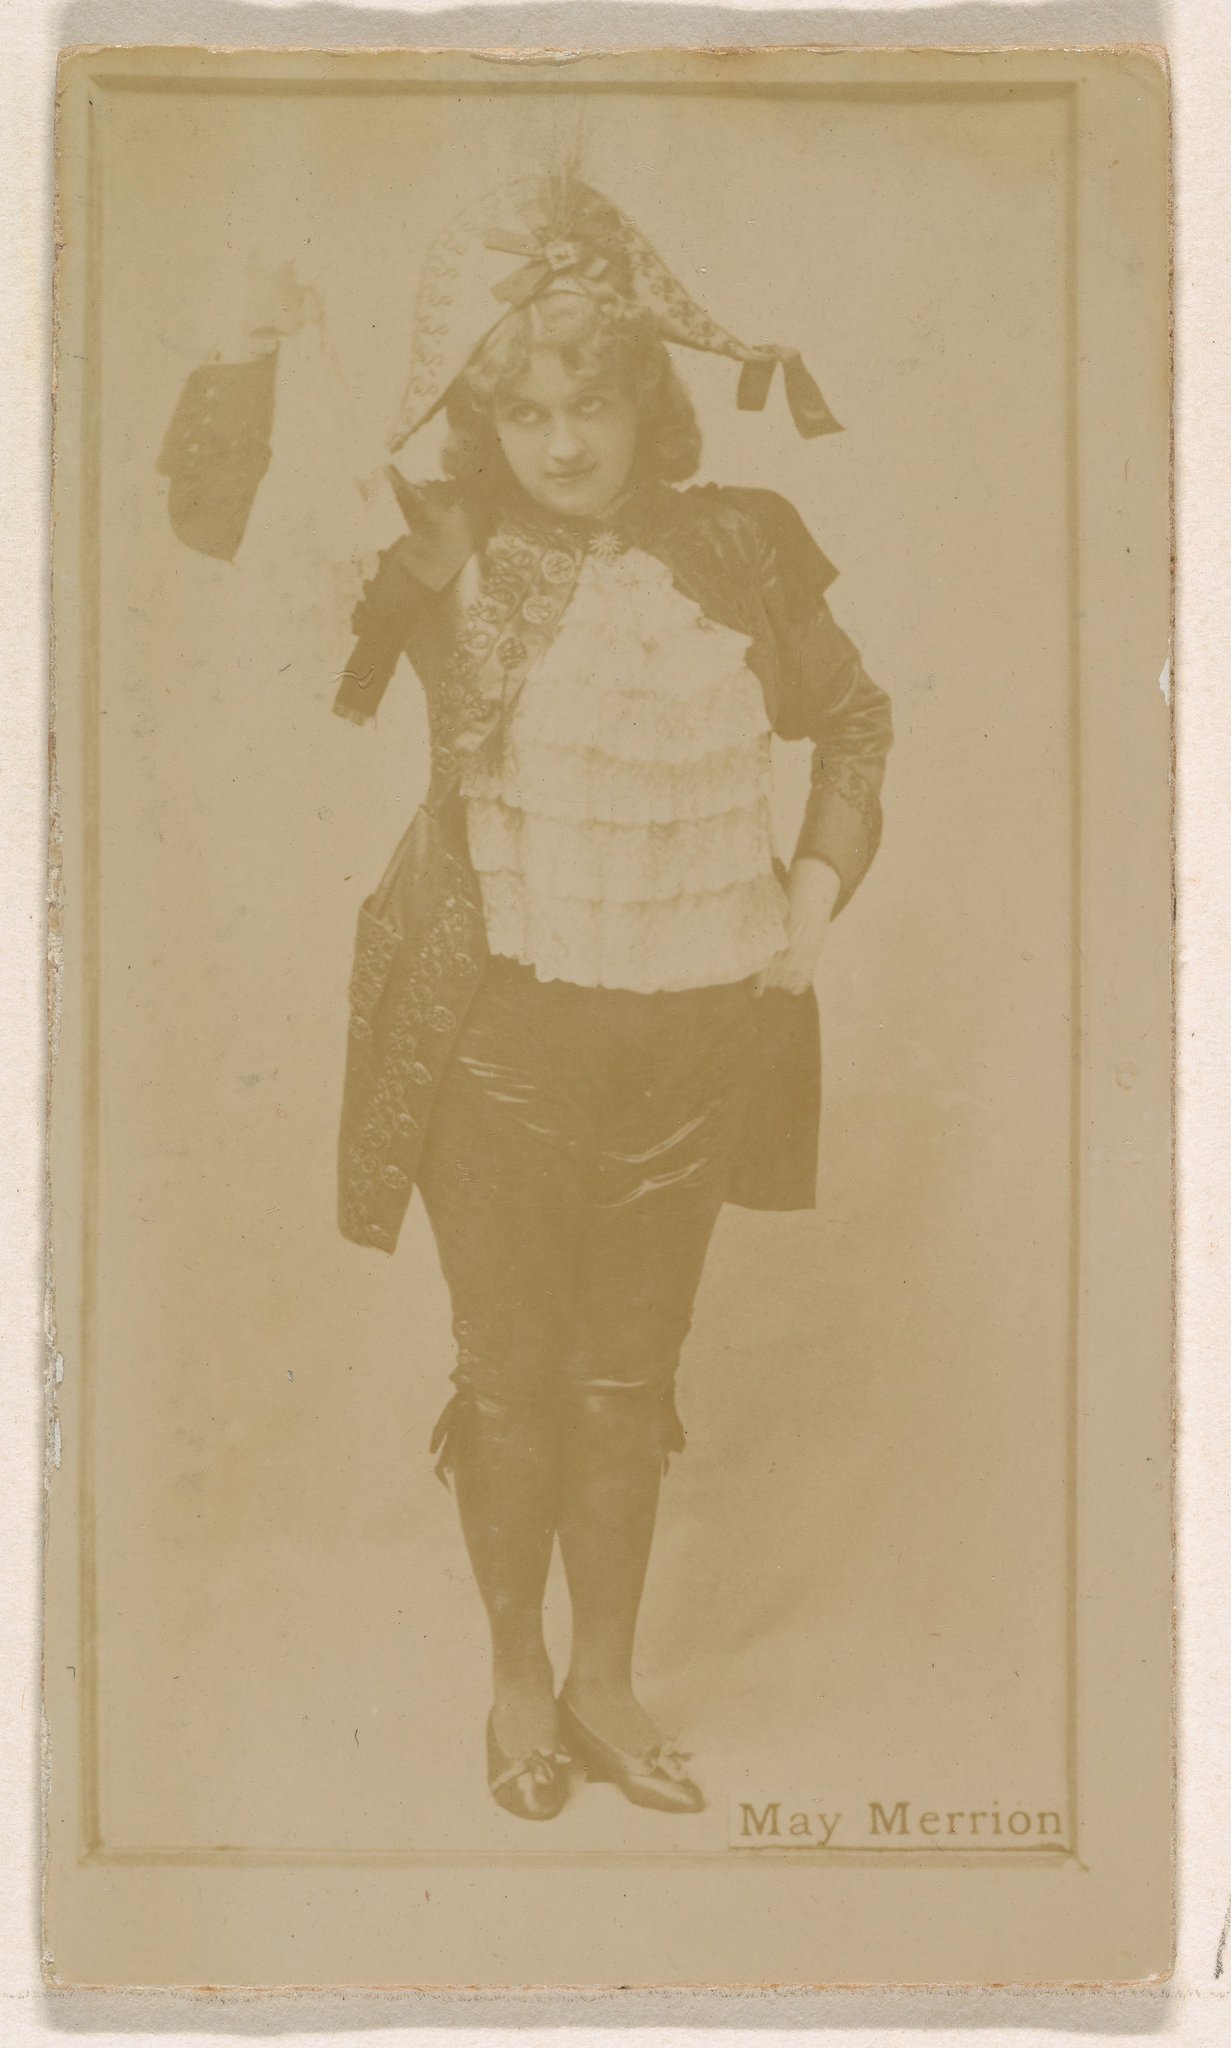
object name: photograph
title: May Merrion, from the Actresses series (N245) issued by Kinney Brothers to promote Sweet Caporal Cigarettes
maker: kinney brothers tobacco company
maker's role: publisher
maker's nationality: american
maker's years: 1869-2011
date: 1890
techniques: albumen silver print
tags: portraits,women,actresses